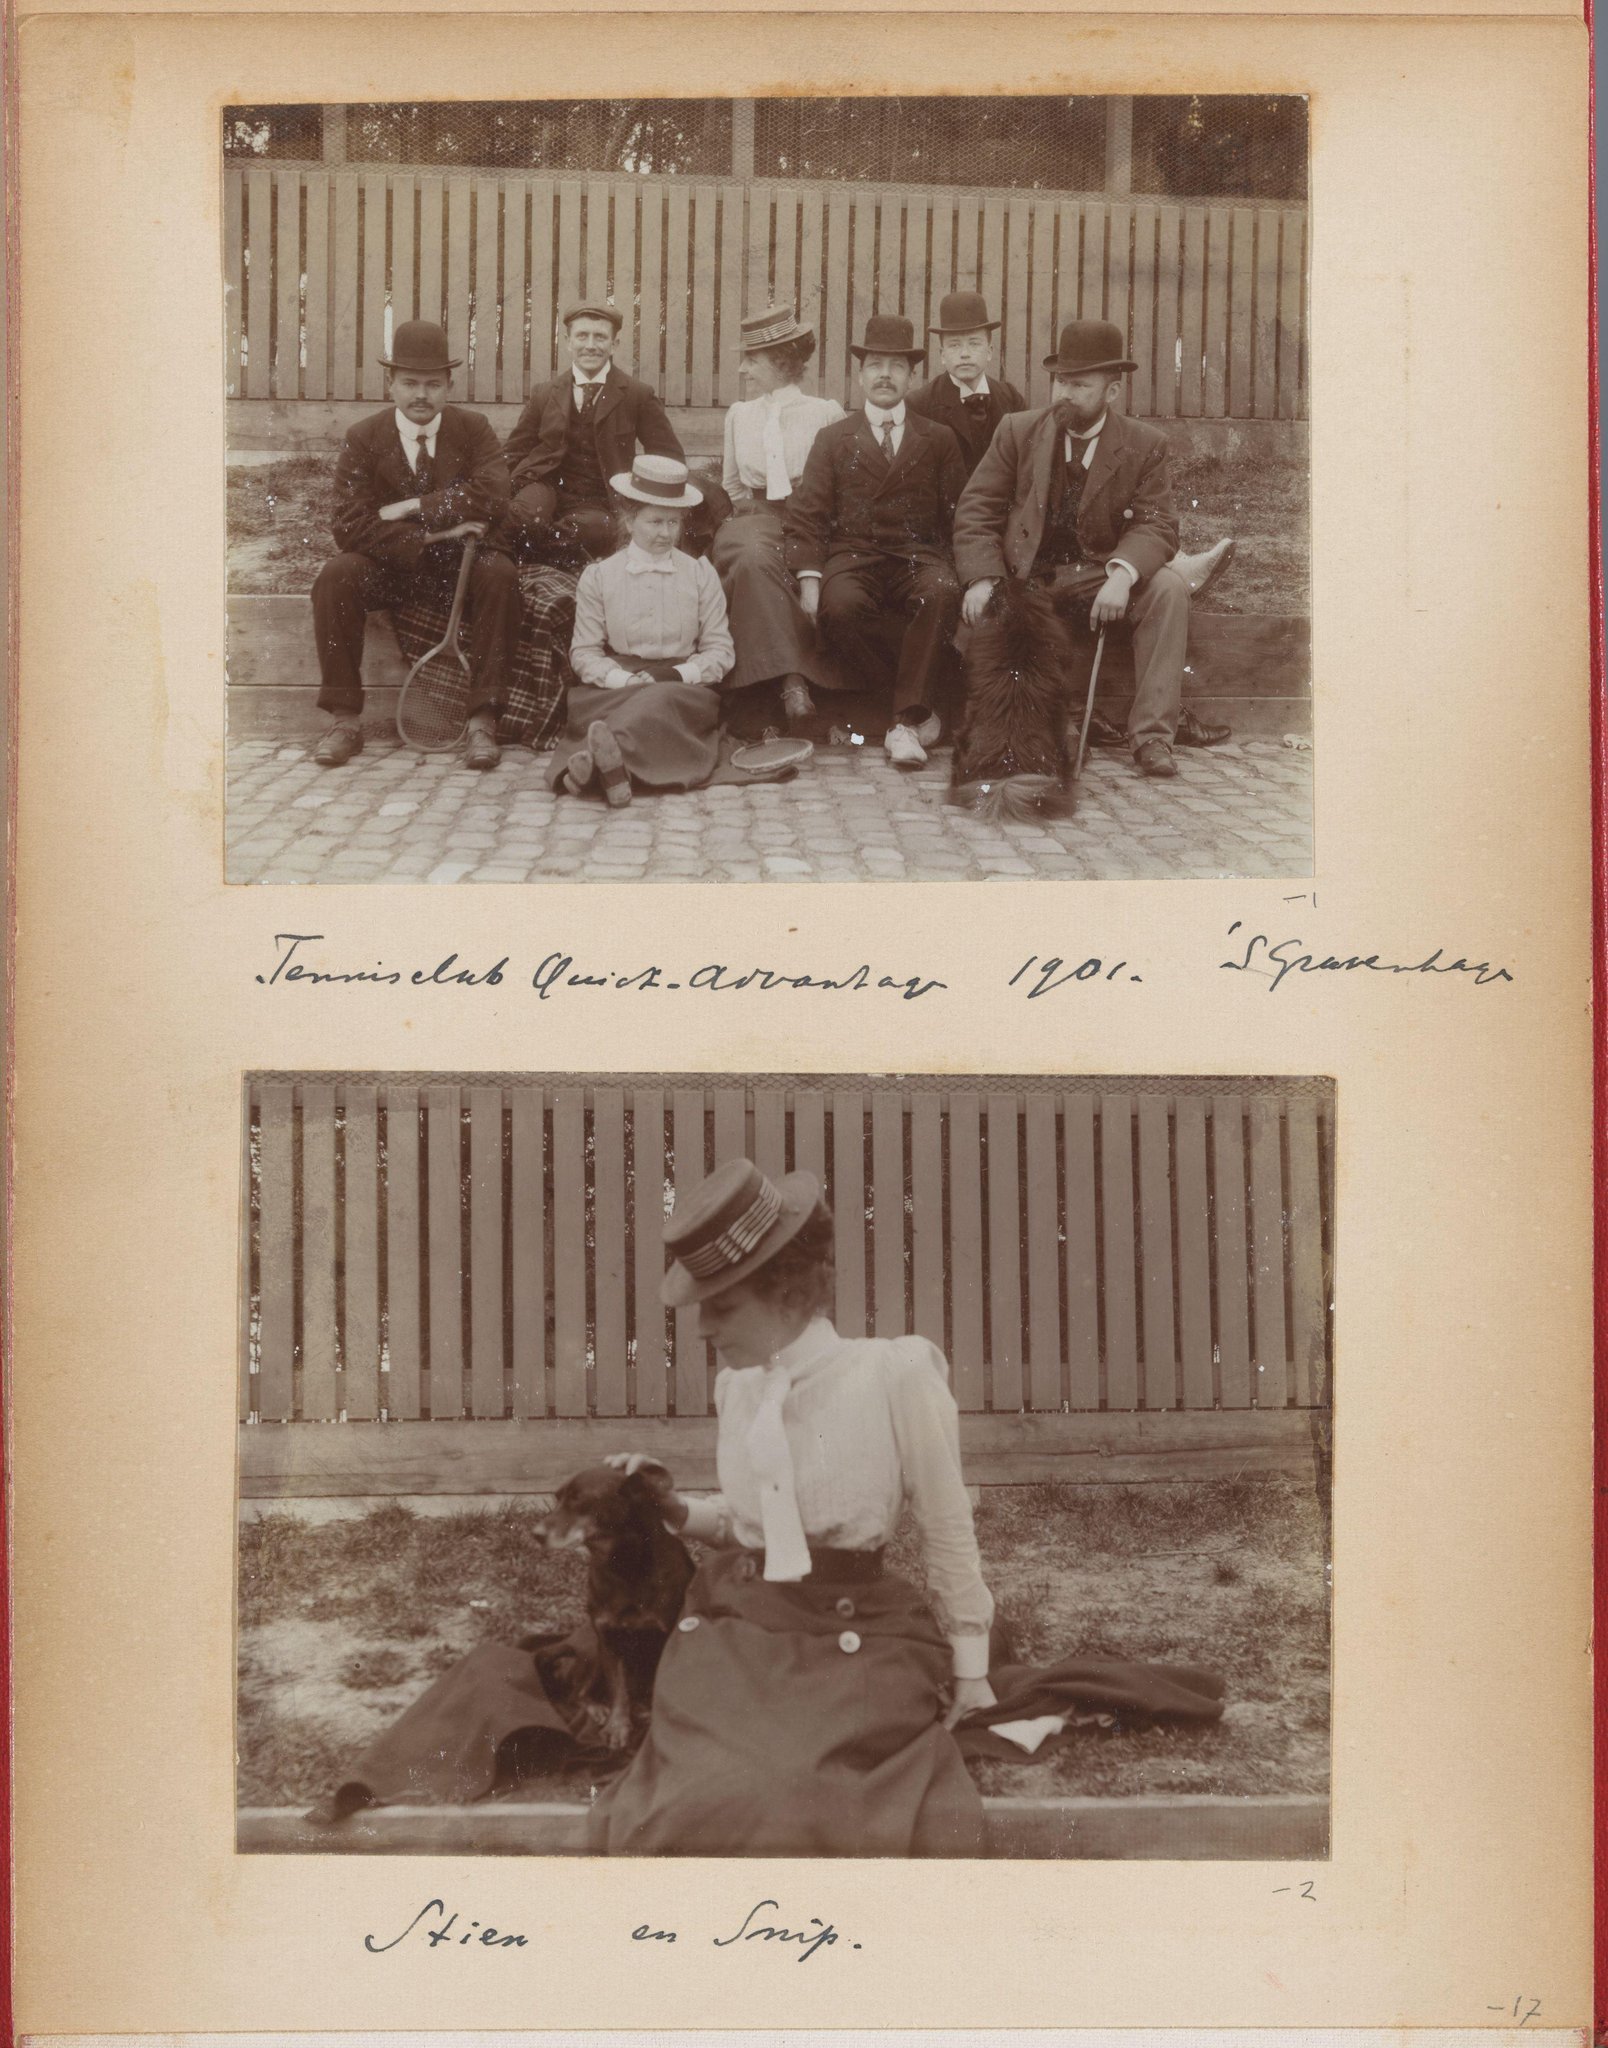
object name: photograph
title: Stien met hond Snip bij Tennisclub Quick Advantage in Den Haag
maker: gerard aalbersberg (us)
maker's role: amateurfotograaf, arts, chirurg, gynaecoloog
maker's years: 1870-1934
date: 1901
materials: paper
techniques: collodion silver print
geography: the hague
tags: the hague